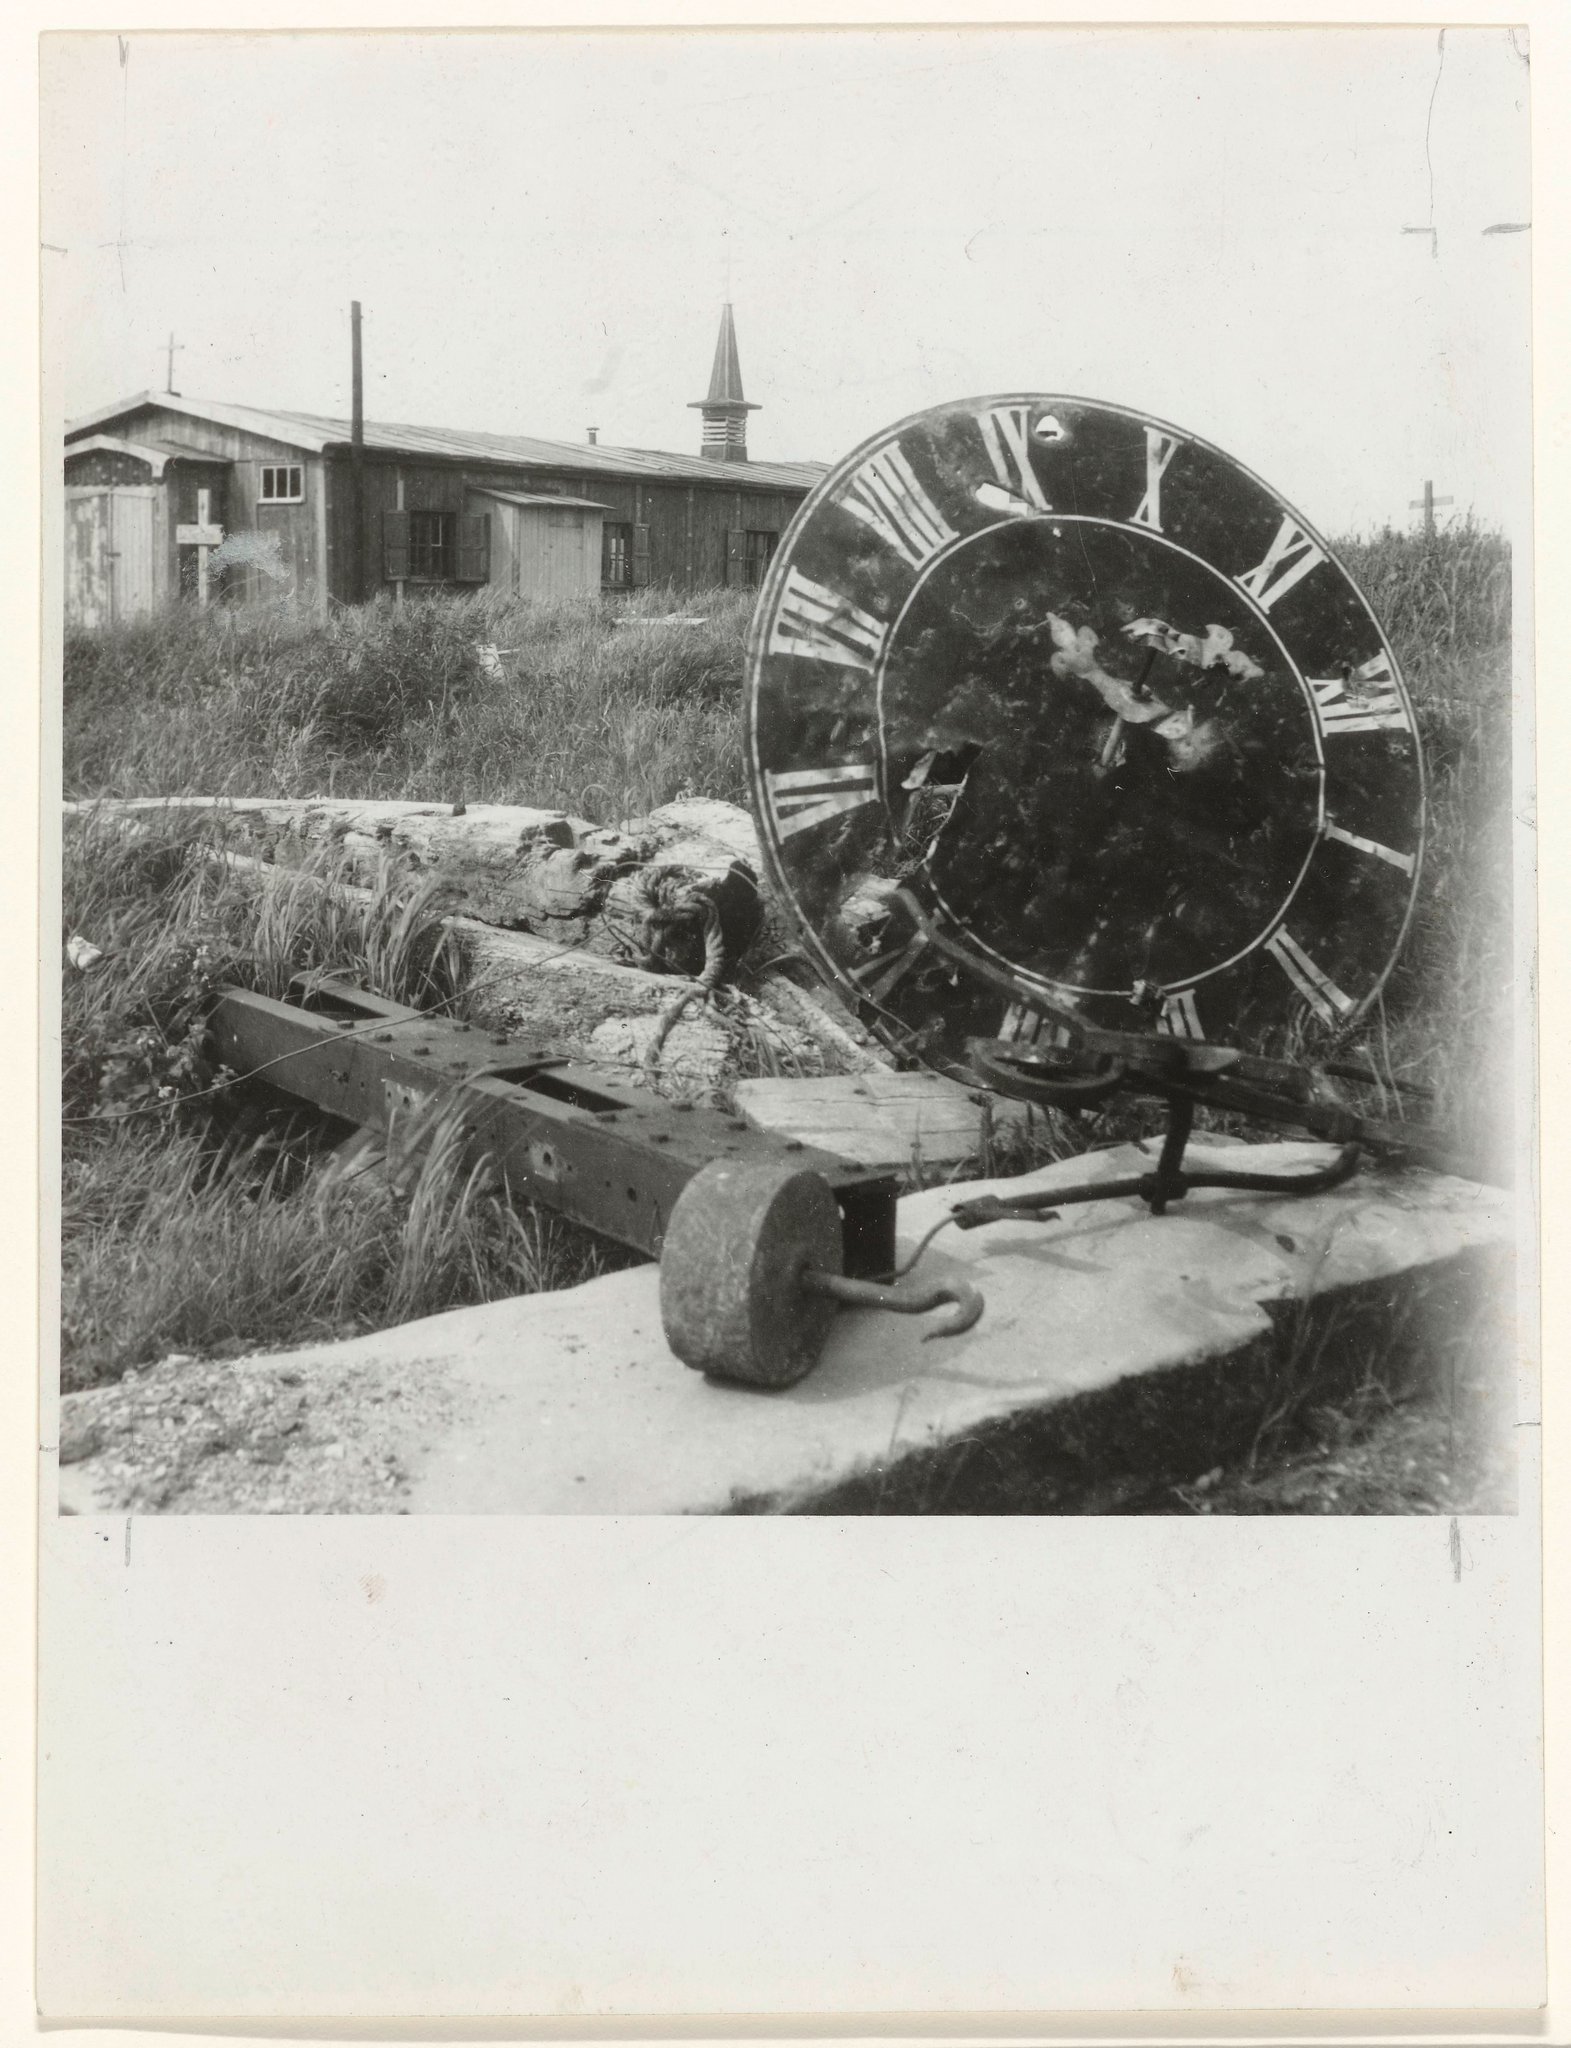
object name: documentary photograph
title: Een kapotte klok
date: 1945-1947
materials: photographic support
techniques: photography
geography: netherlands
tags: publisher, netherlands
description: Op een paar houten balken ligt een kapotte wijzerplaat van een klok. Op de achtergrond staat een houten gebouw.